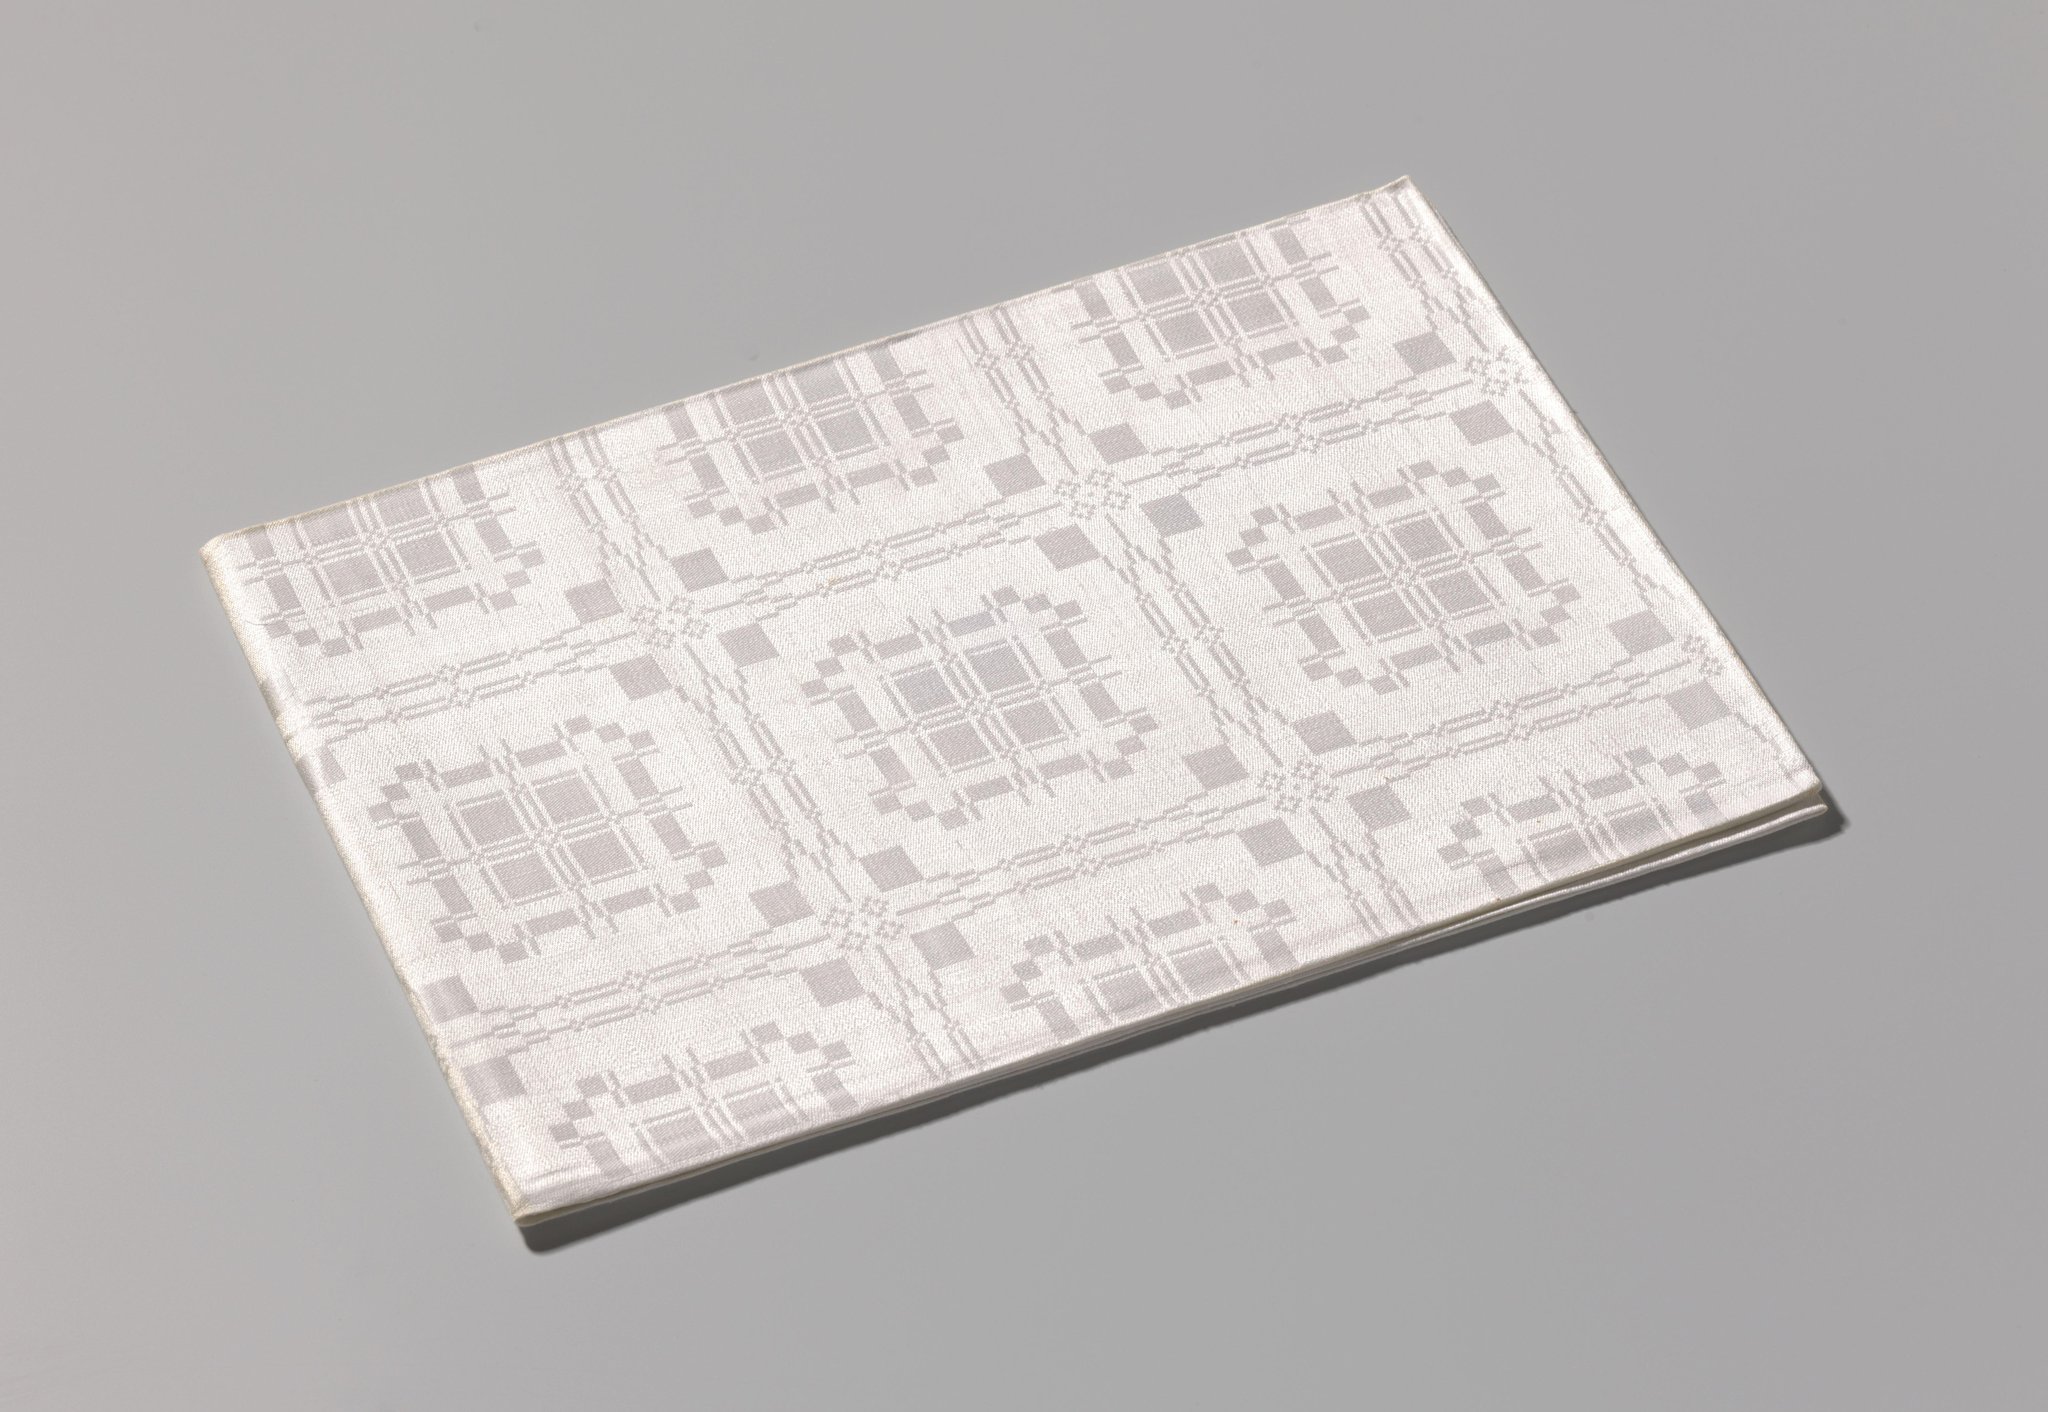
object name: napkin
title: Servet van wit linnen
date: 1400-1950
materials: linen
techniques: peeled fabric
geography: northern netherlands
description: Wit linnendamasten servet met pellenpatroon, merk kroon IS en 36.